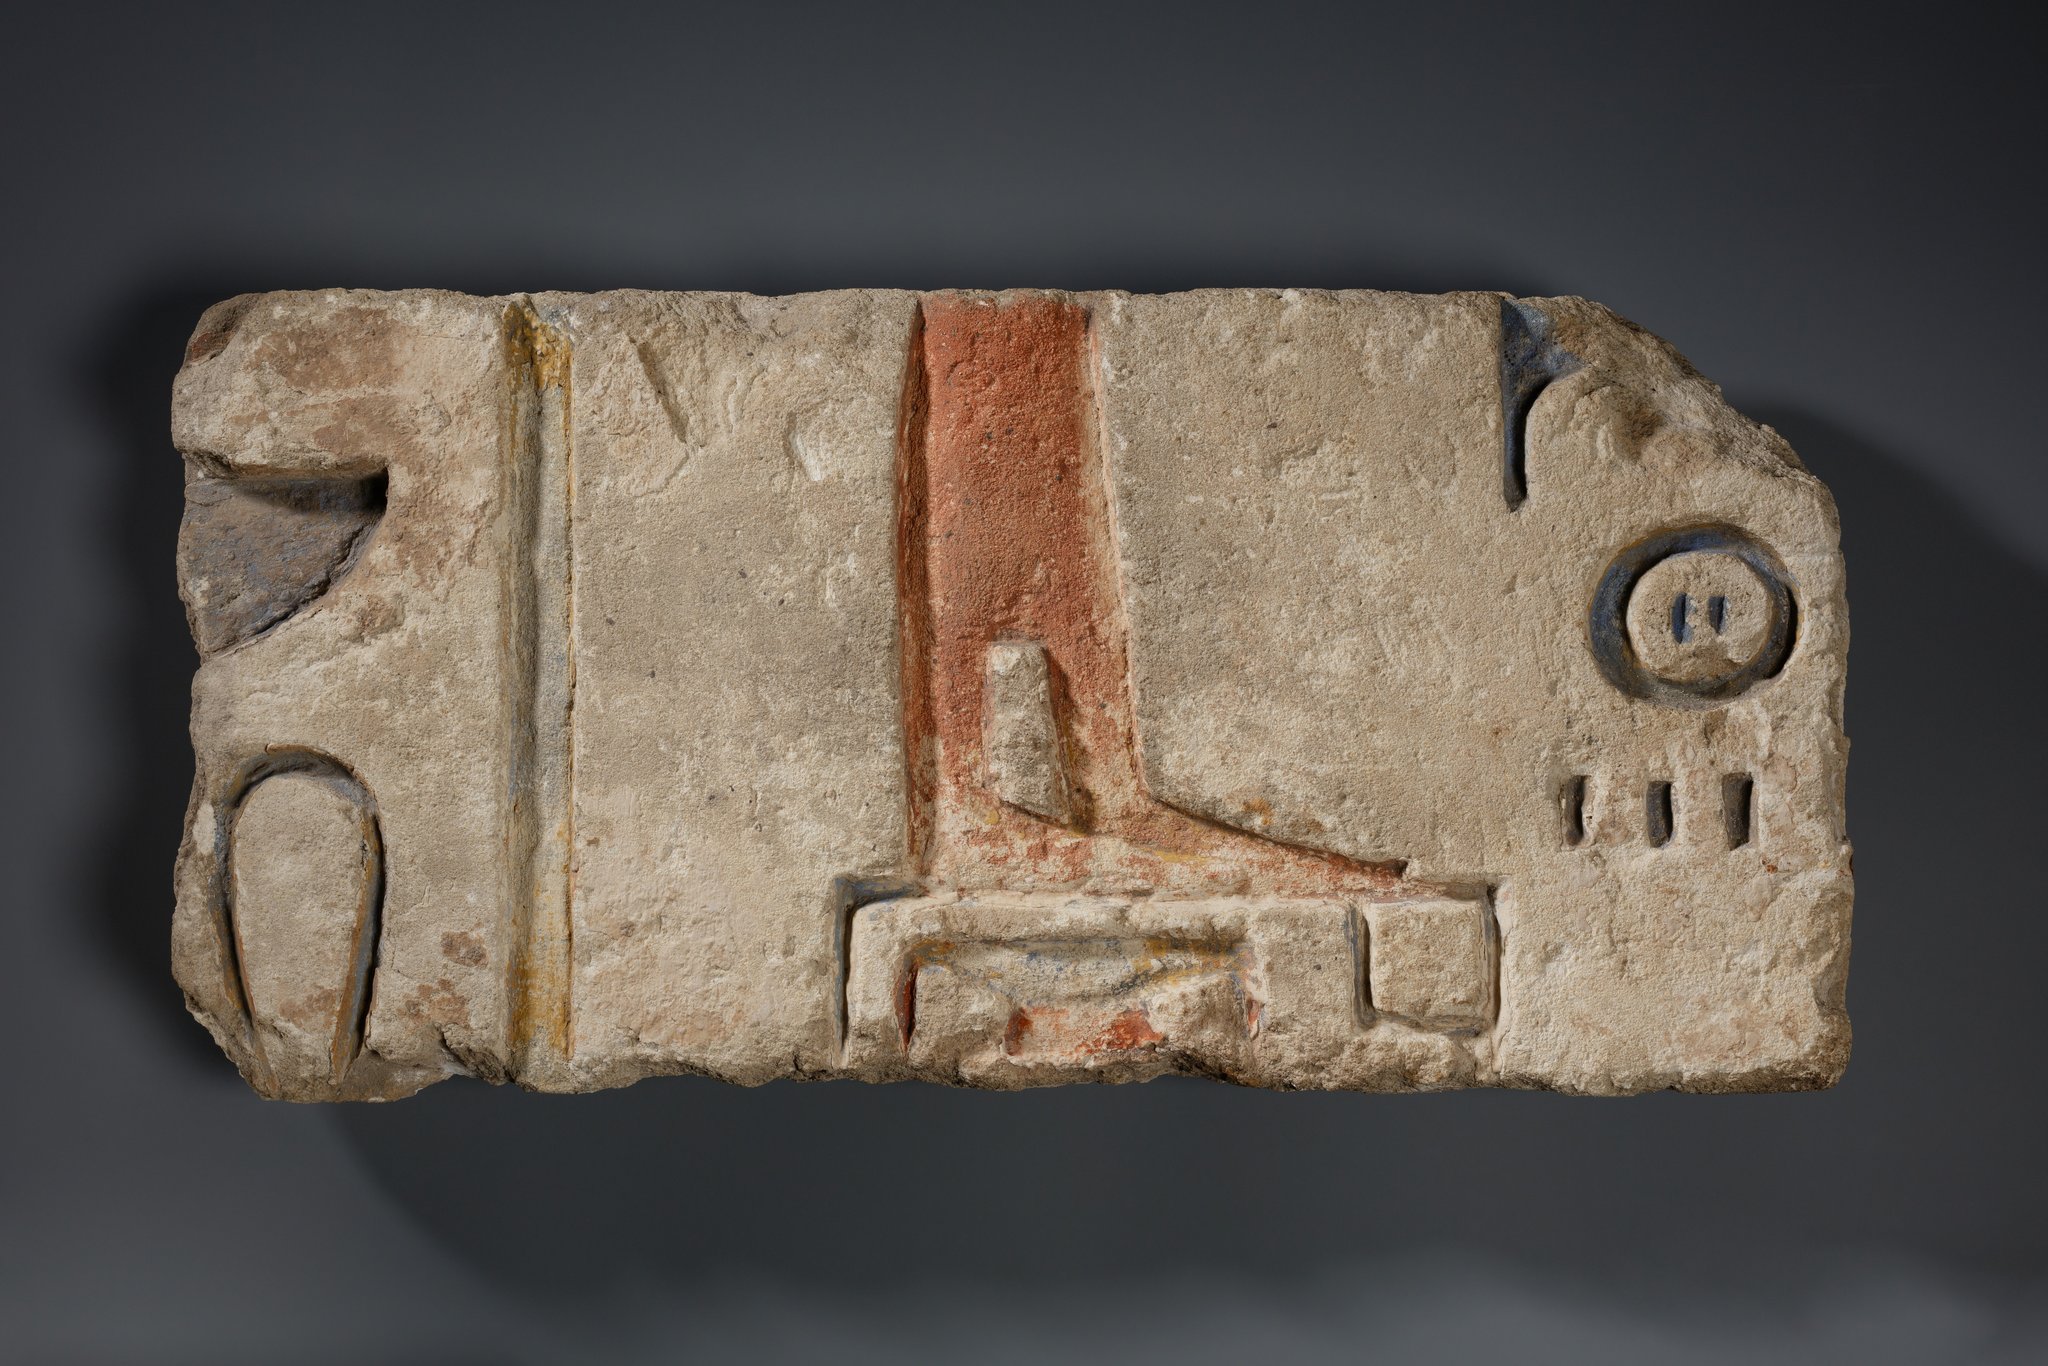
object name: relief, figure of a goddess, pr nbw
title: Relief fragment with a figure of a goddess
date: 1295-1186 BCE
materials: limestone, paint